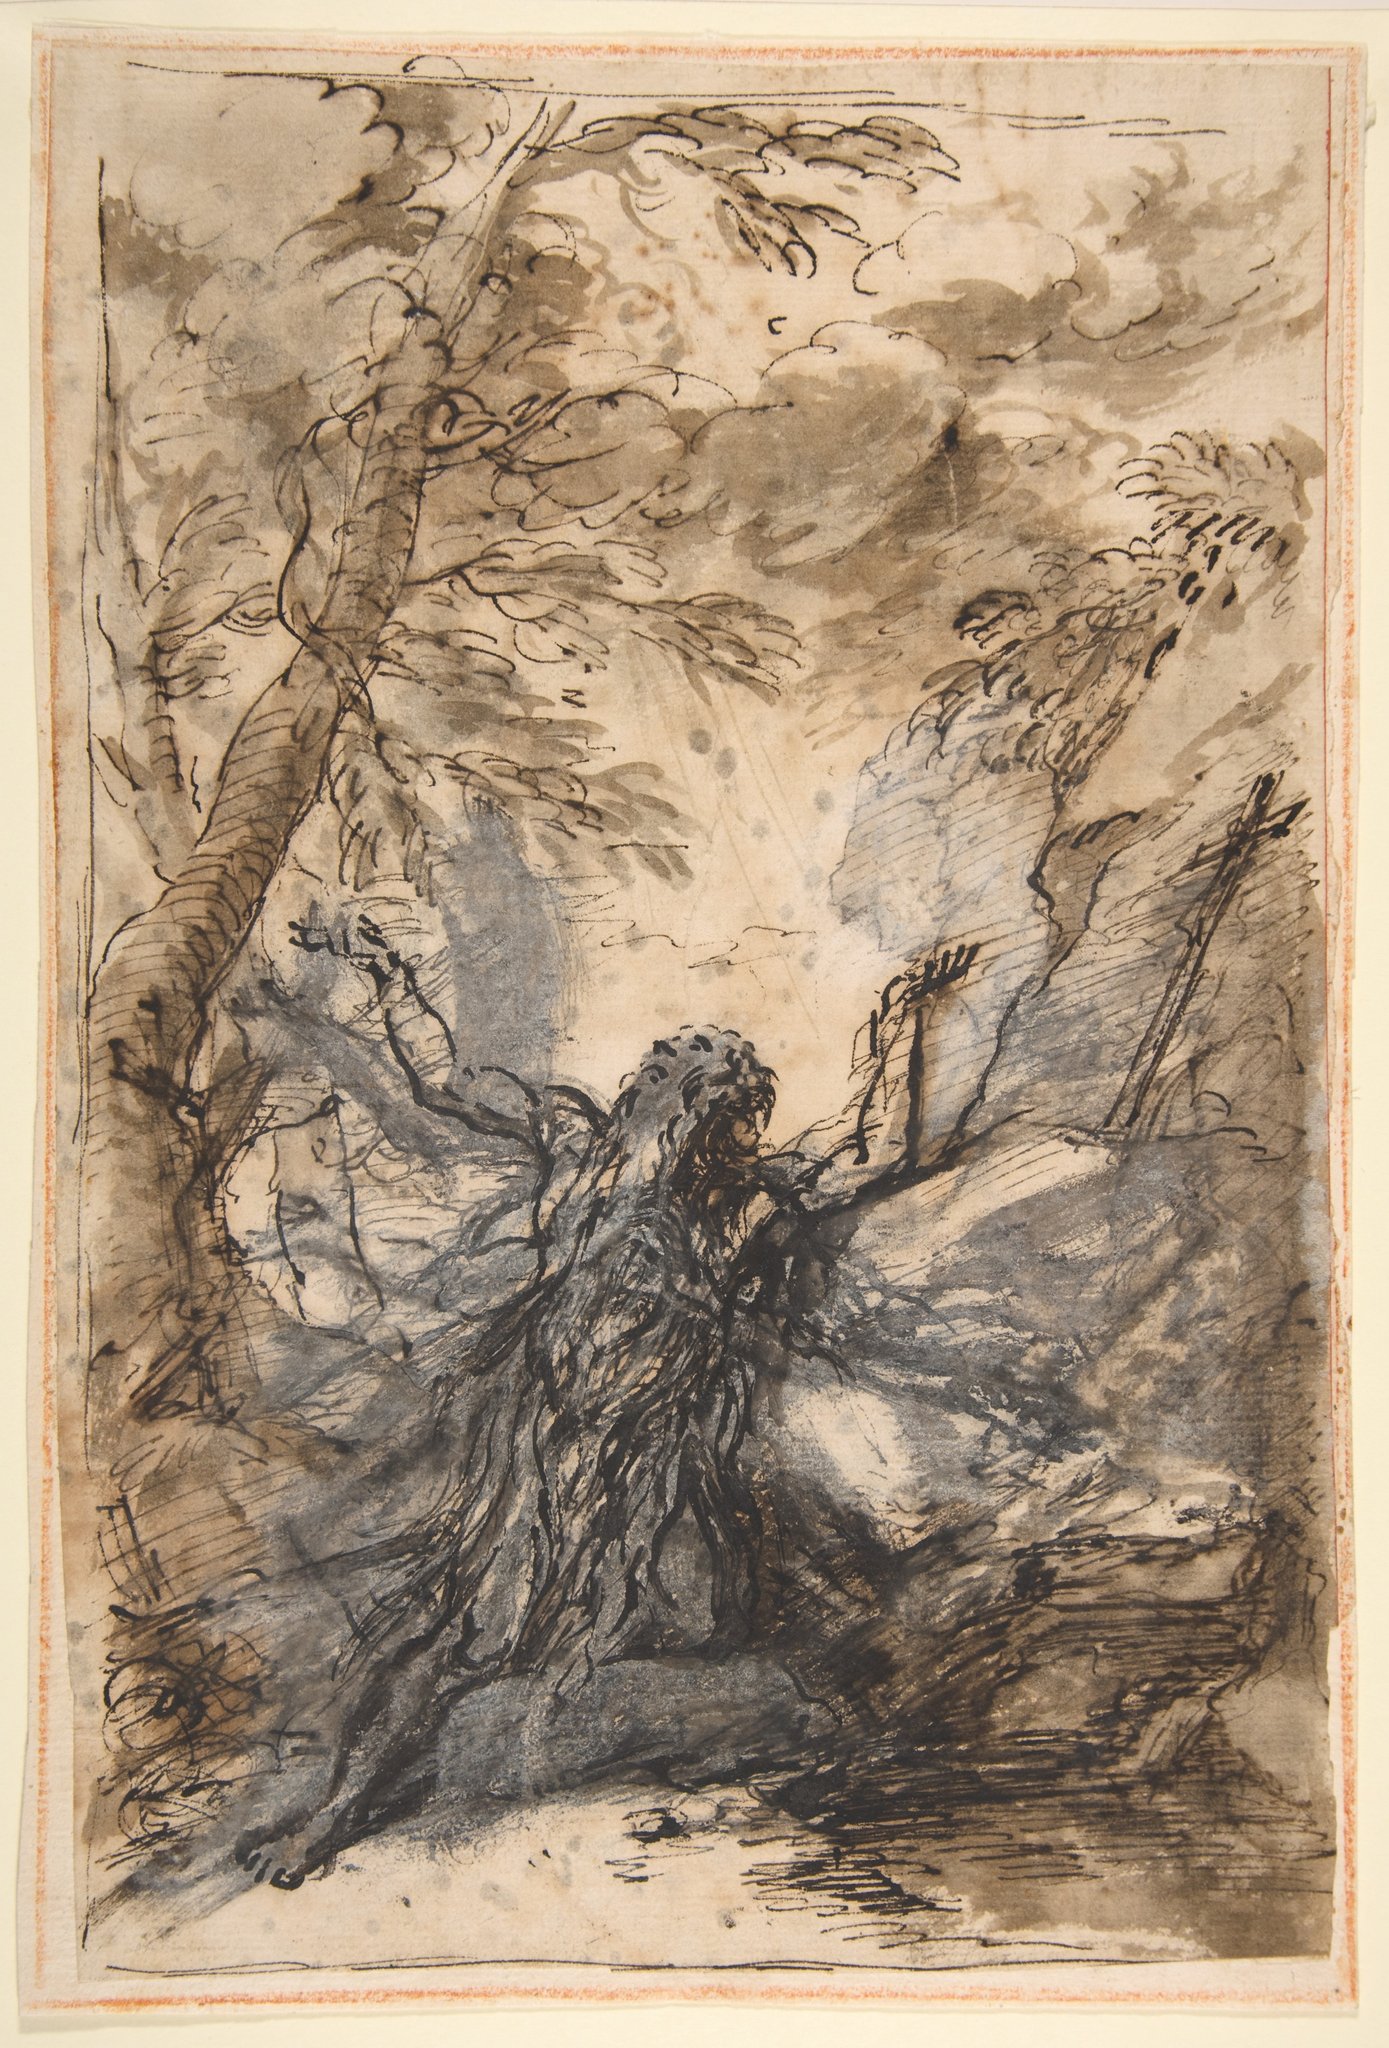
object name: drawing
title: St. Paul, Hermit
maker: salvator rosa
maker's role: artist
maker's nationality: italian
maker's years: 1615-1673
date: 1635-1673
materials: chalk, gouache, ink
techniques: highlighting, pen, wash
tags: saint paul,cross